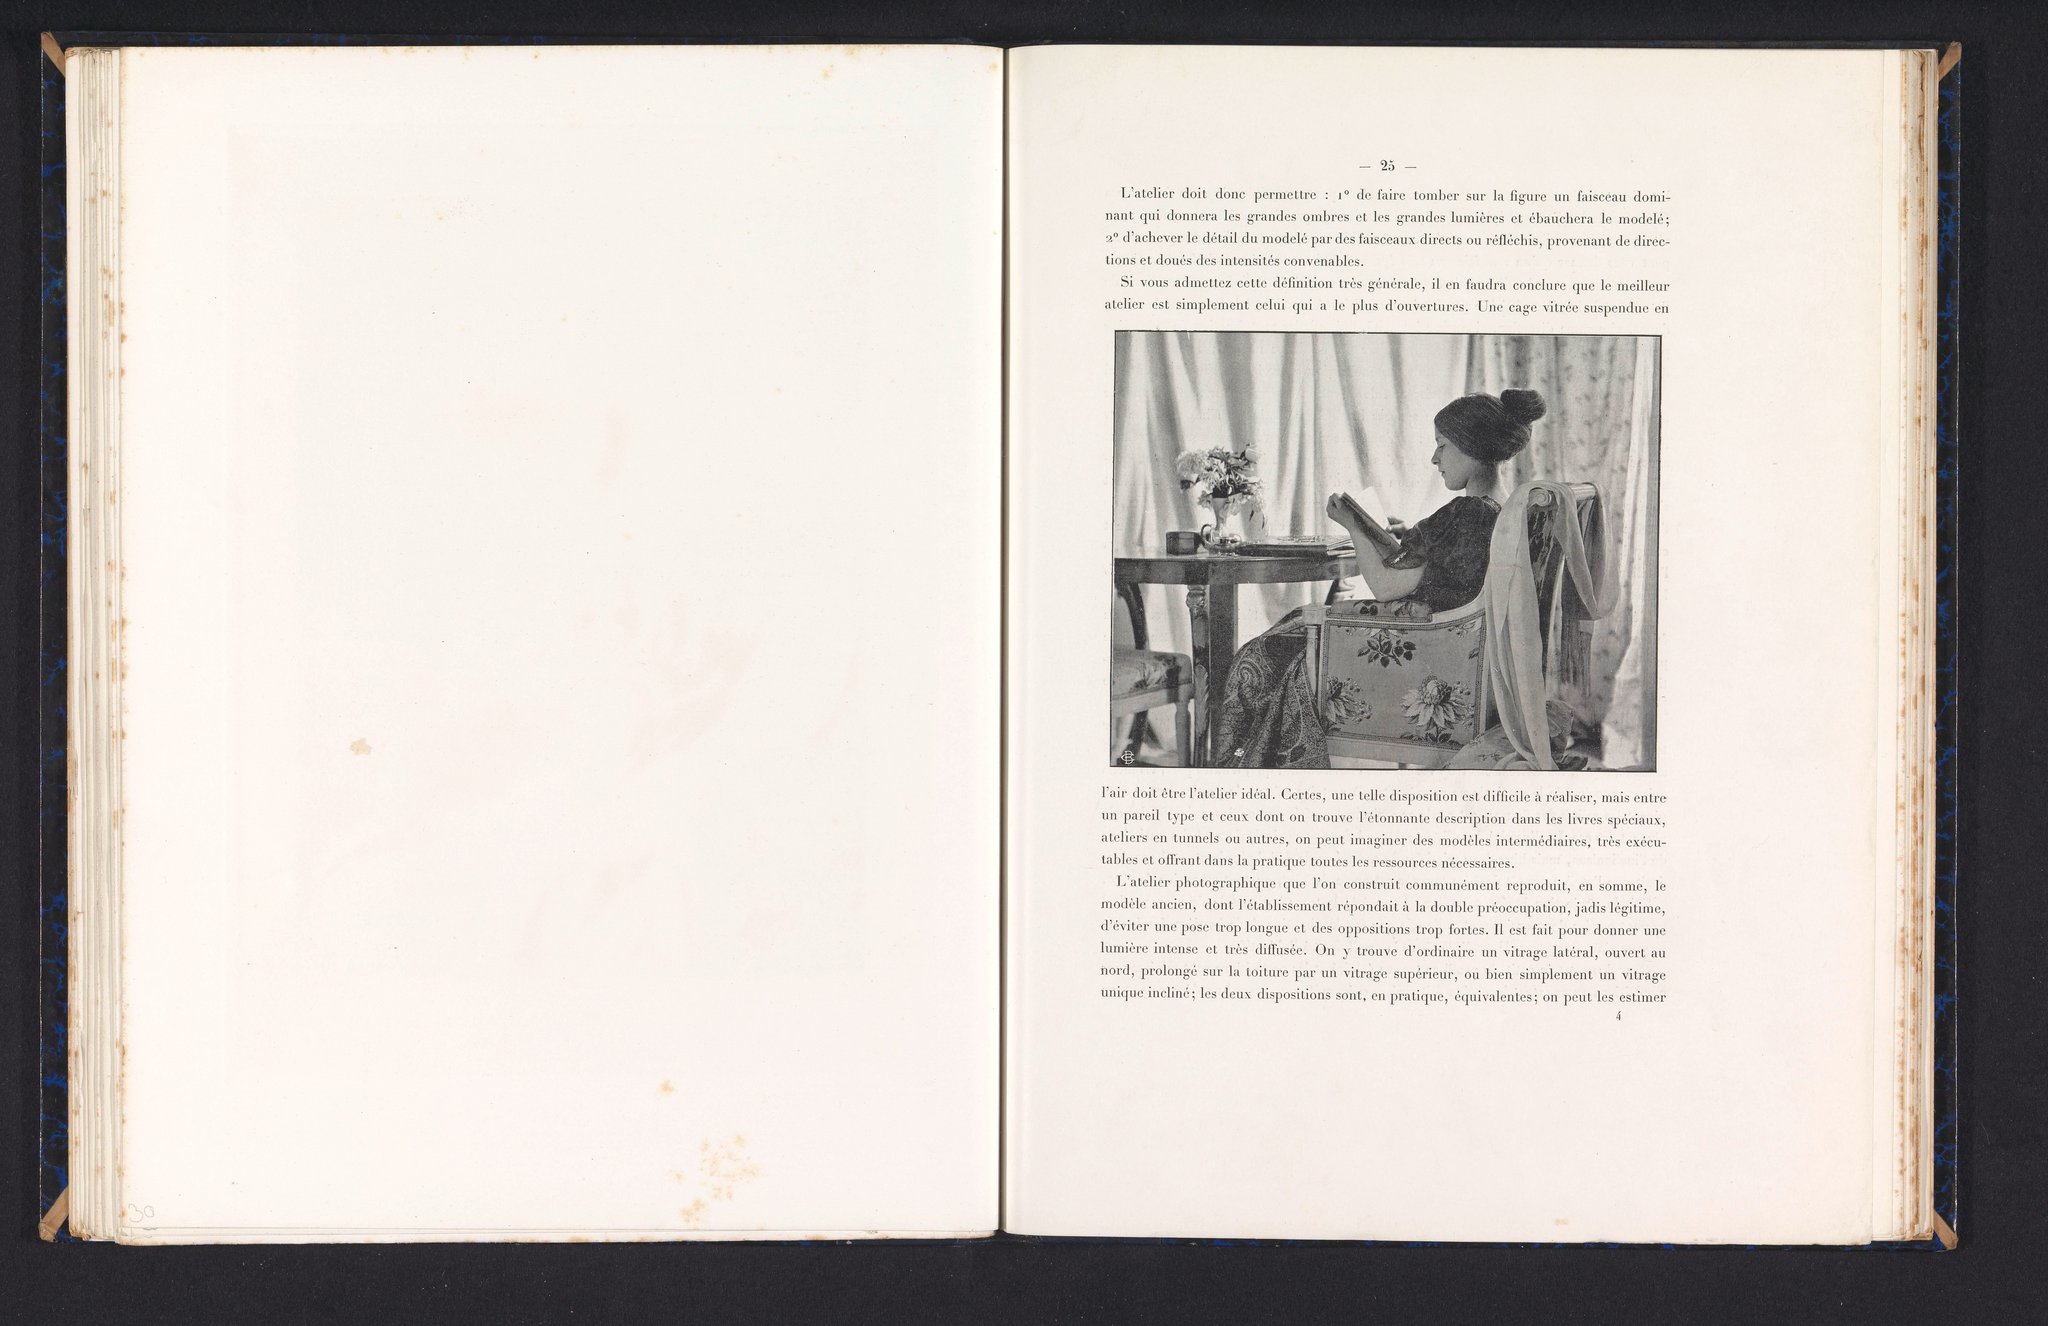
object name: page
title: Lezende vrouw in een stoel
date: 1886-1896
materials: paper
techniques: autotype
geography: france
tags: adult woman, reading, chair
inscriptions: inscription: ‘CB’